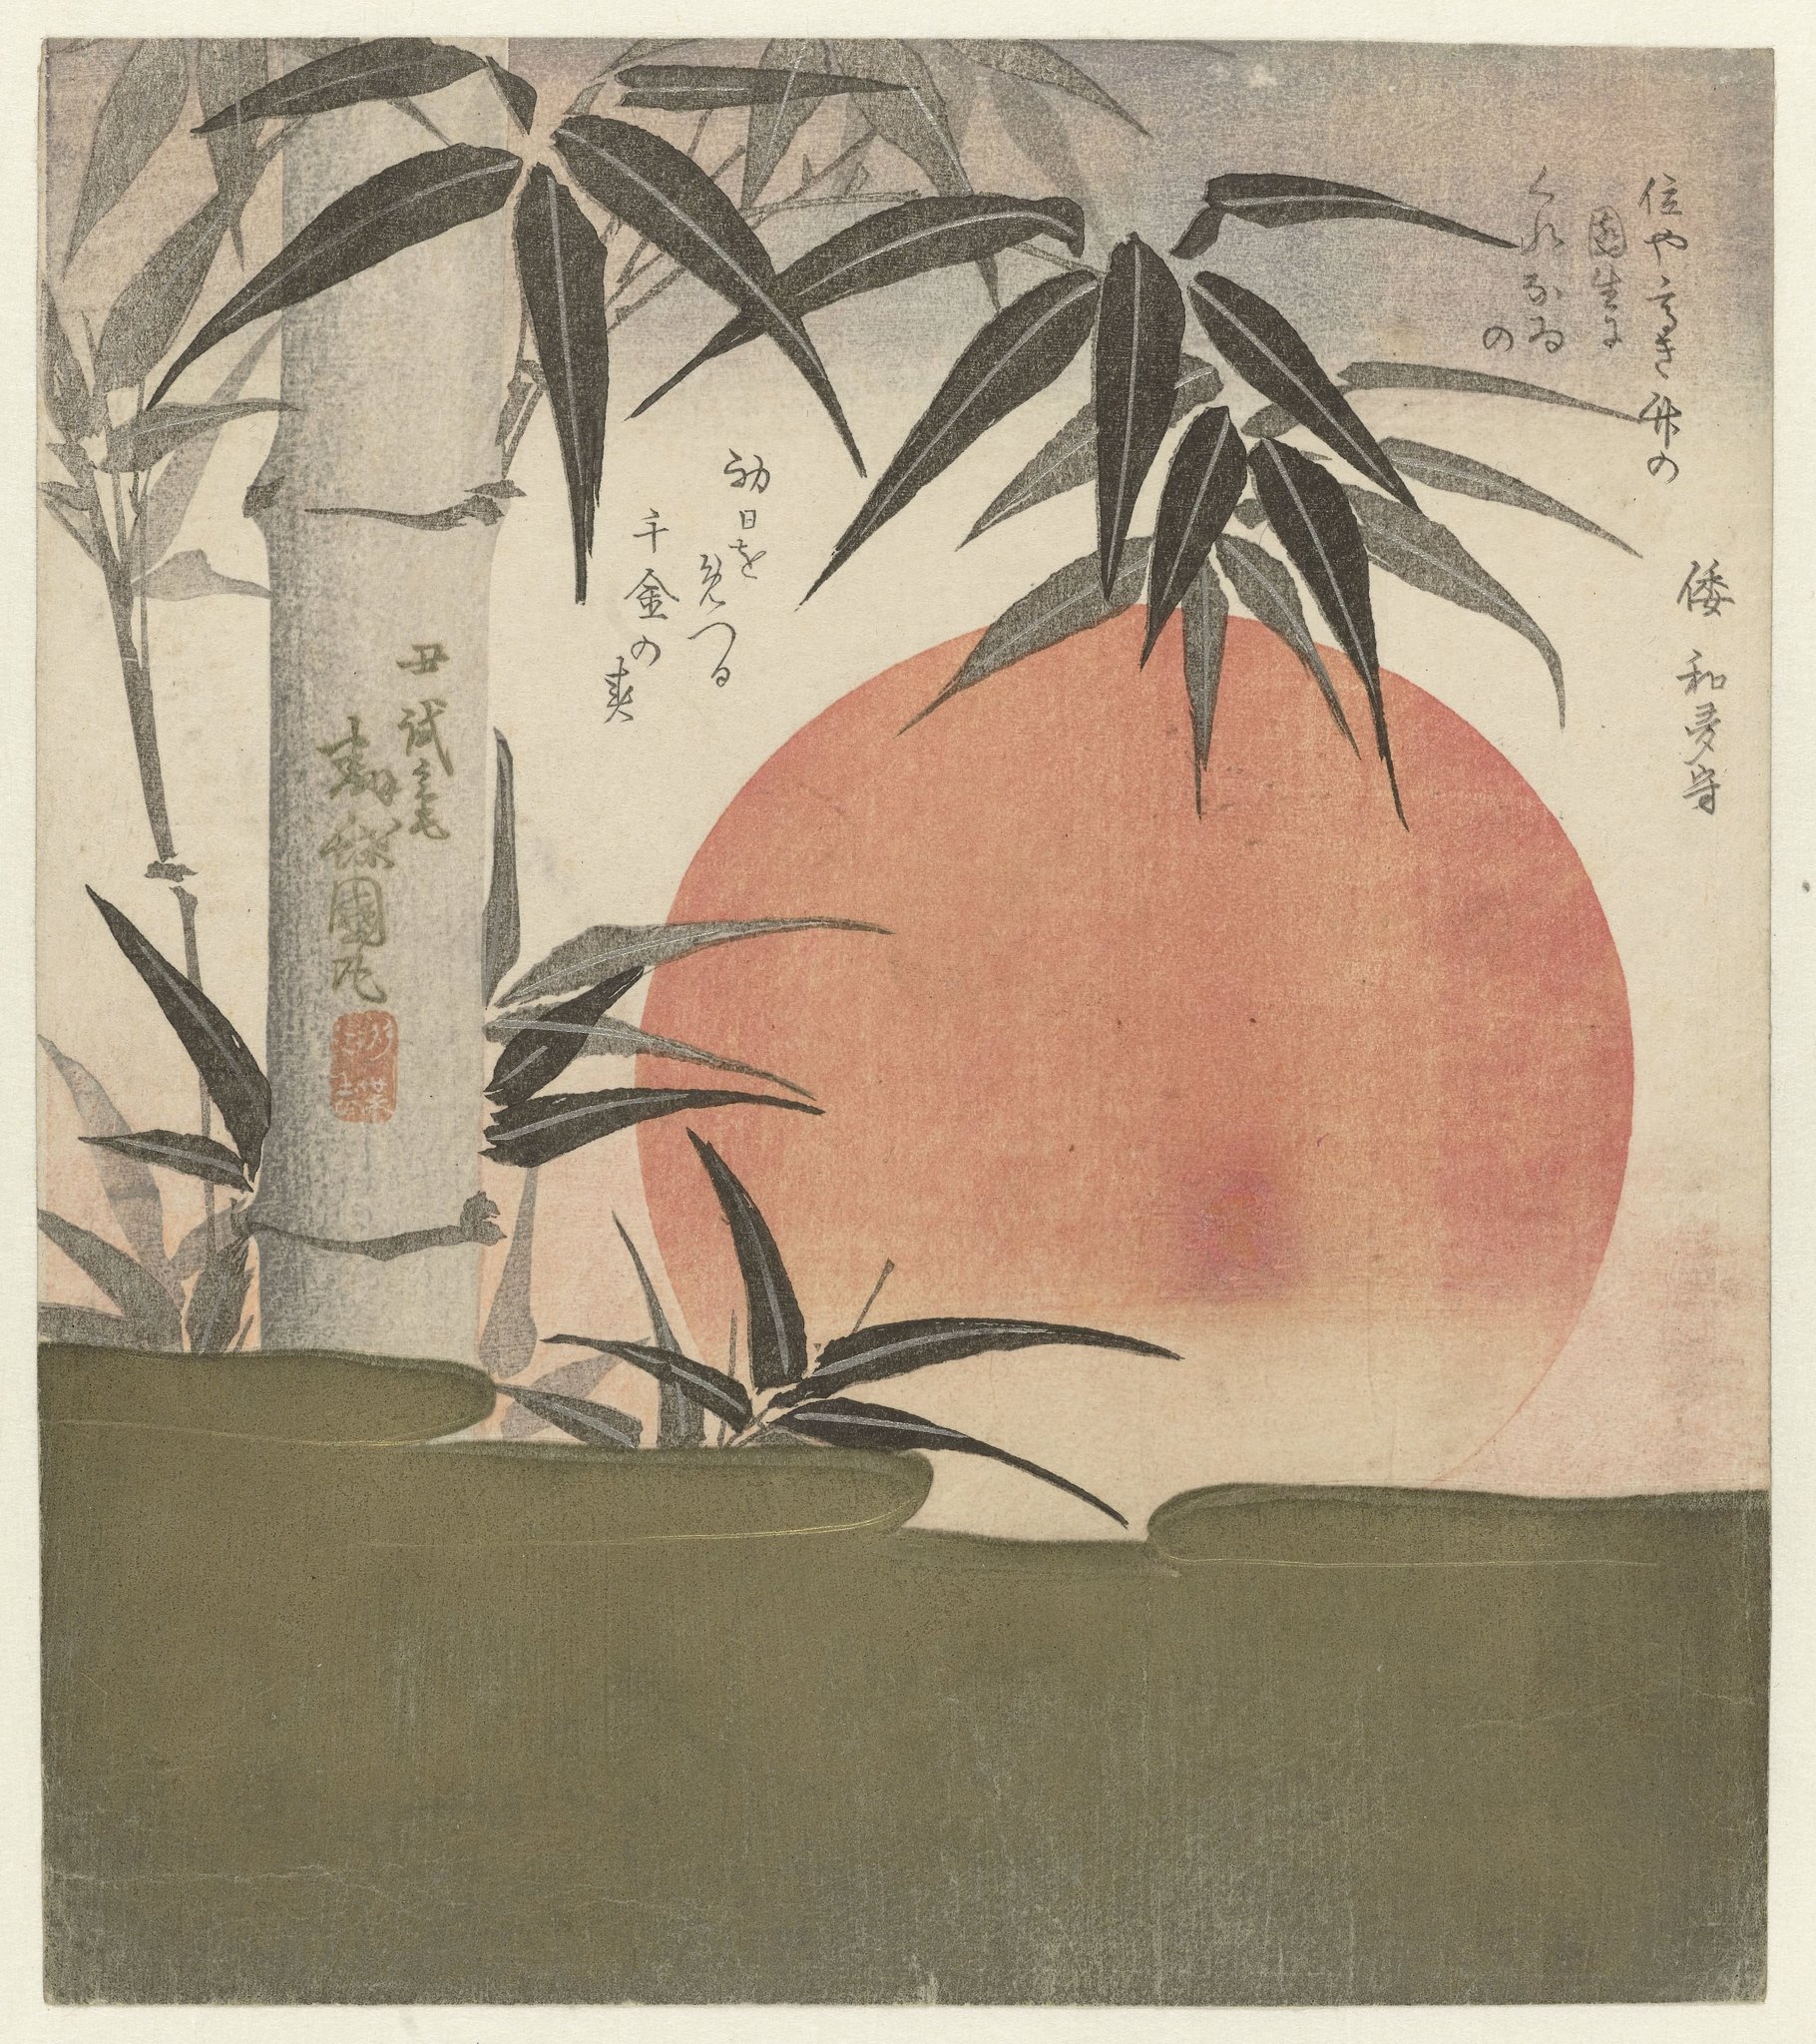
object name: surimono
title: Bamboo and rising sun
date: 1829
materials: paper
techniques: woodcut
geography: japan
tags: sunrise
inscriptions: collector's mark, collector's mark: Lugt 2228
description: Een surimono is een luxe uitgevoerde prent waarop beeld met één of meerdere gedichten gecombineerd is. Bij het drukken van een surimono werd vaak gebruik gemaakt van dikker papier, blinddruk en metaal pigmenten, zoals koper- en zilverpoeder. De prenten werden vaak in opdracht van dichters gemaakt en als exclusief geschenk aan vrienden en relaties gegeven.